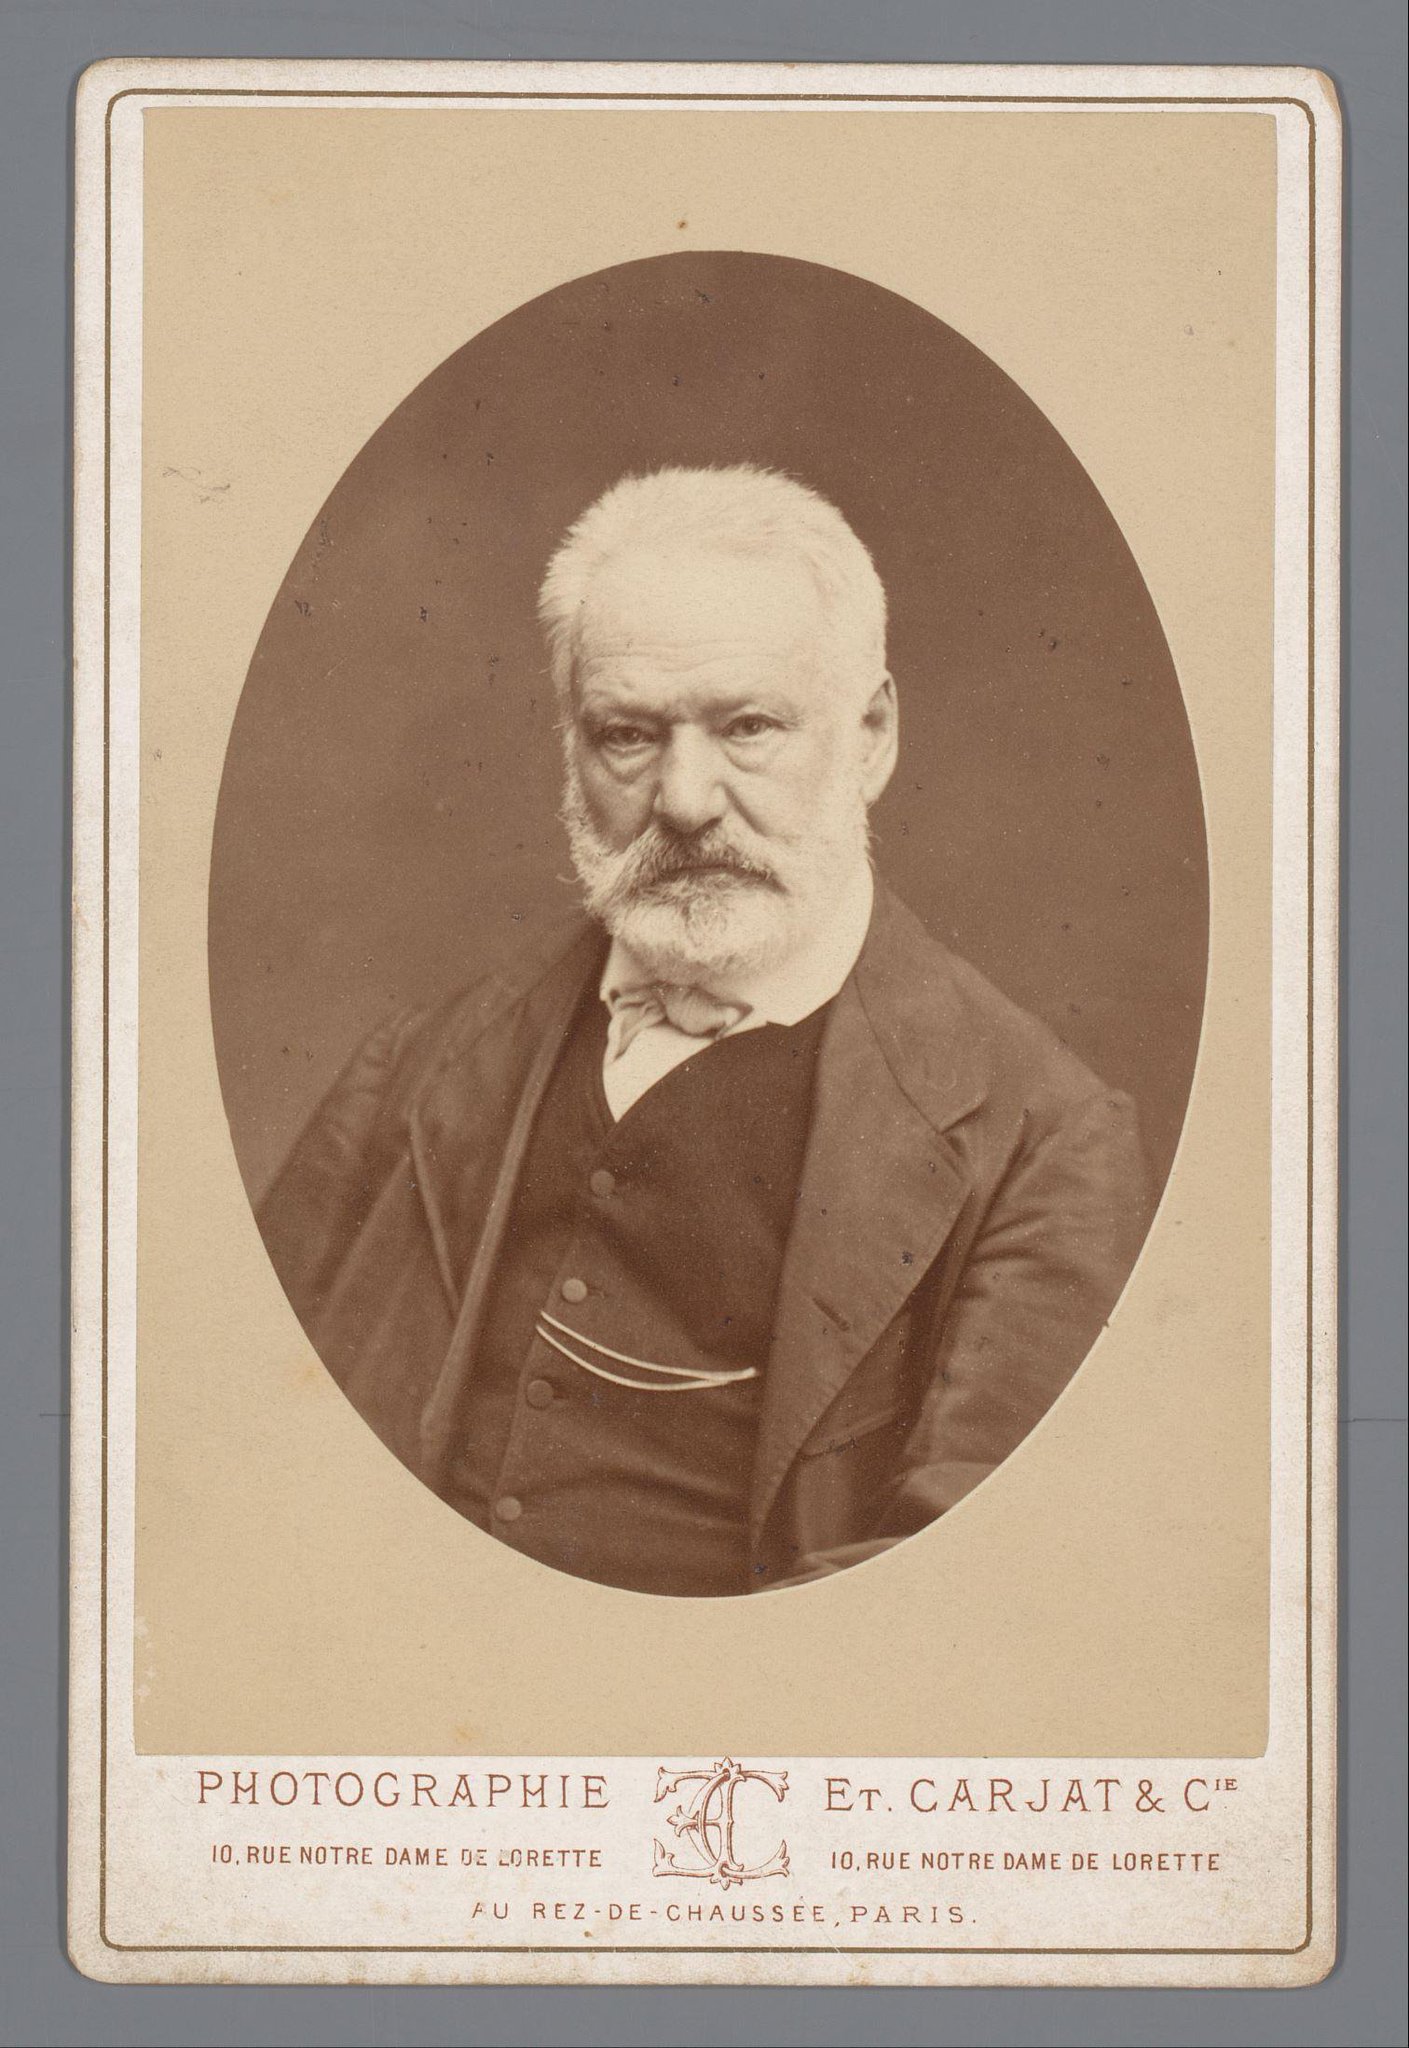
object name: photograph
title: Portret van Victor Hugo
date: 1870-1890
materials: cardboard, paper, photographic support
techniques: albumen print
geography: paris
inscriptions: caption: ‘PHOTOGRAPHIE ET. CARJAT & CIE//10.RUE NOTRE DAME DE LORETTE [hiertussen staat EC] 10. NOTRE DAME DE LORETTE//AU REZ-DE-CHAUSSEE, PARIS.’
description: Portret van de Franse schrijver Victor Hugo